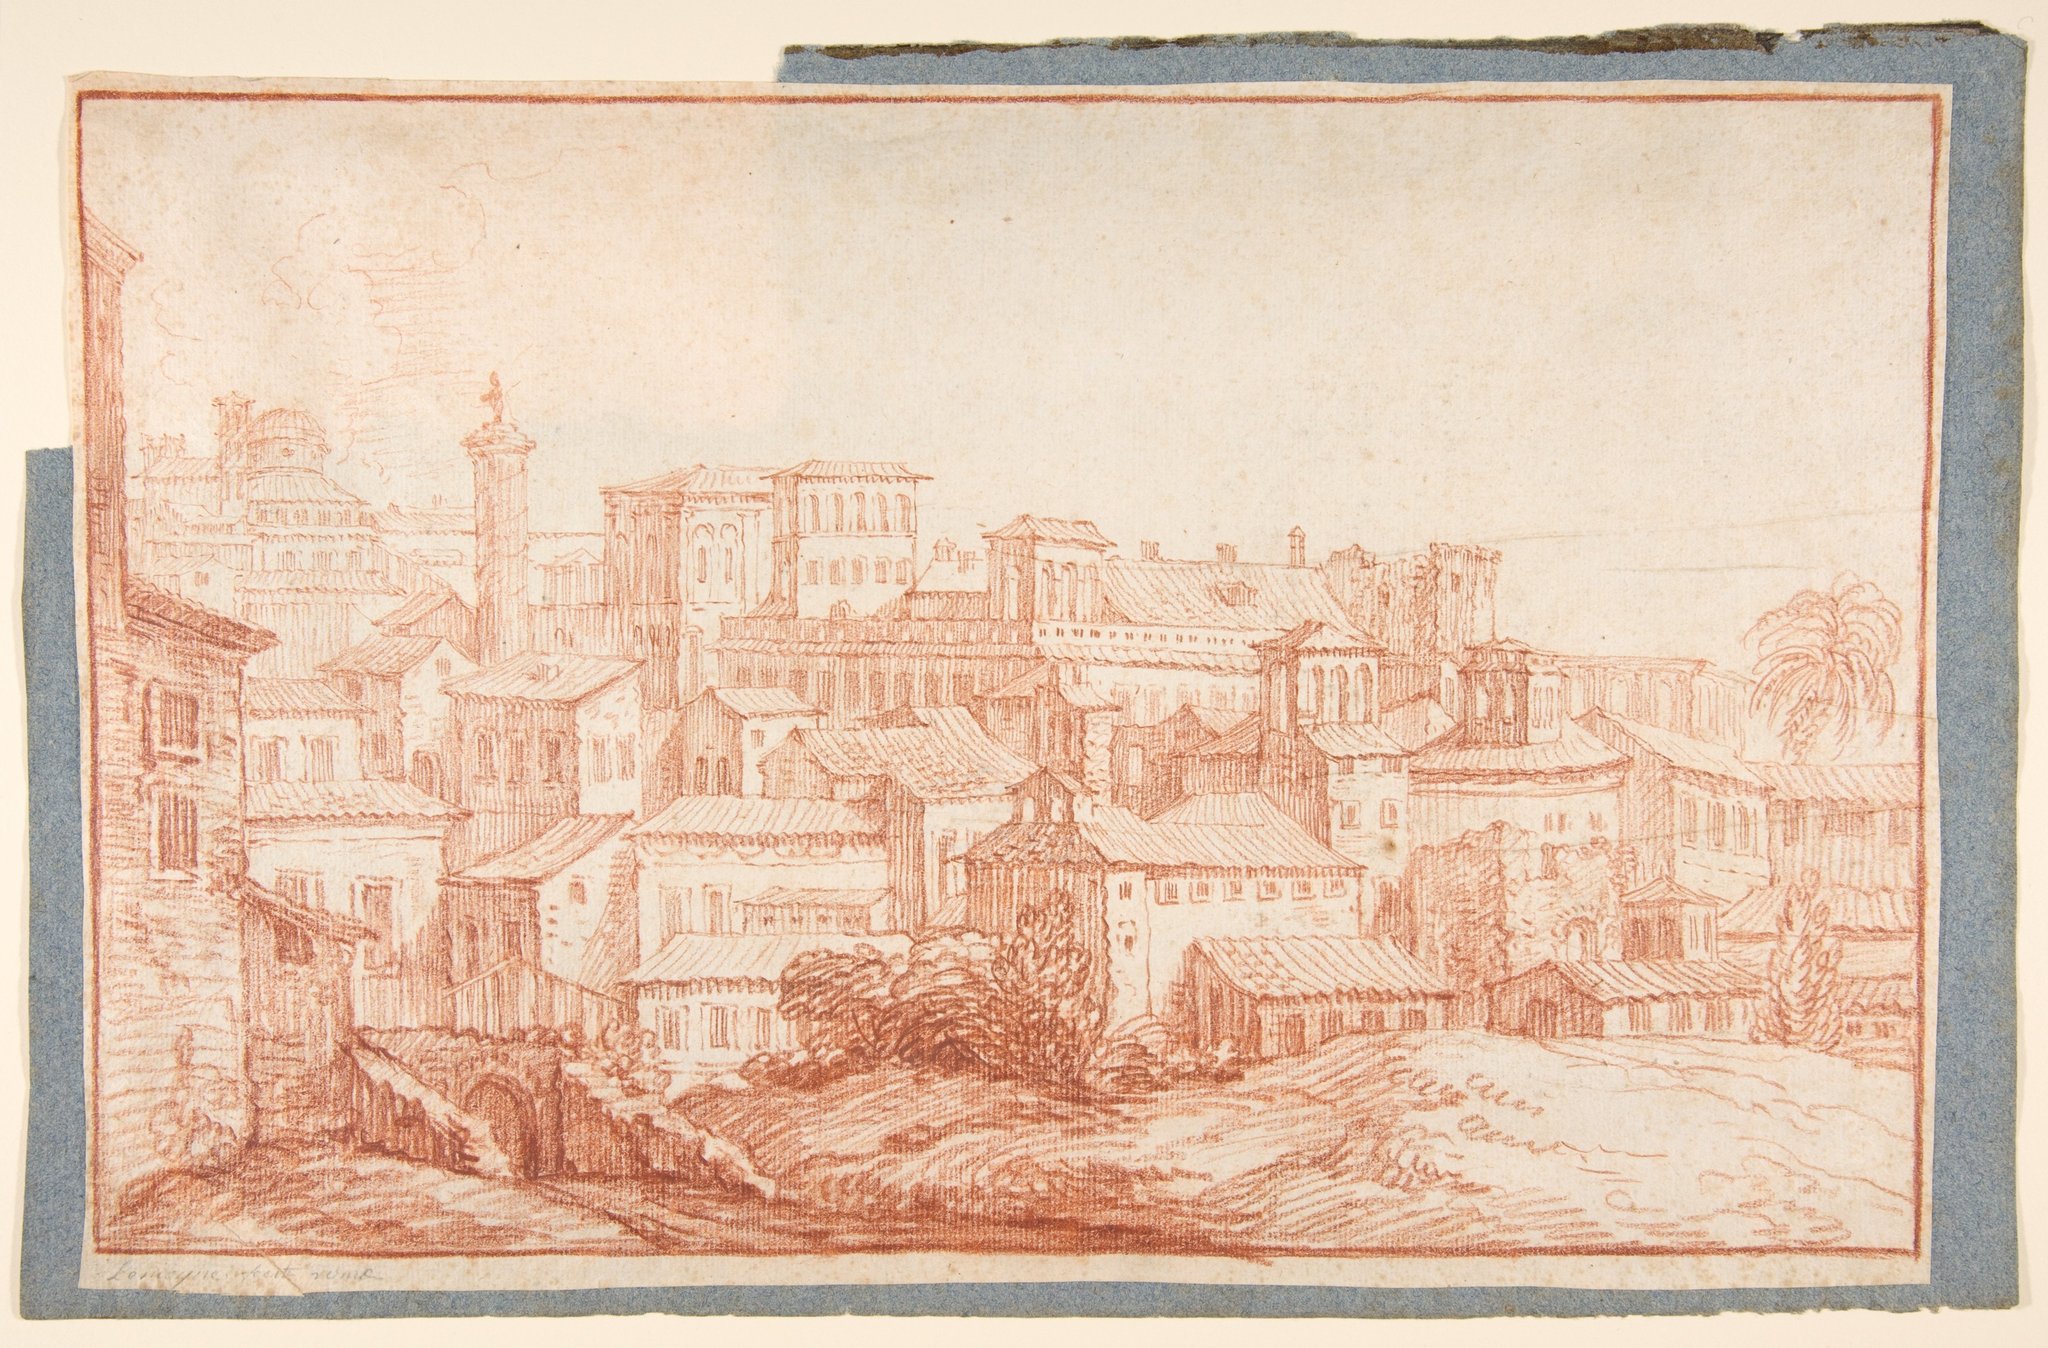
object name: drawing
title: View of Rome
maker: françois le moyne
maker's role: artist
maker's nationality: french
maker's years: 1688-1737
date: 1724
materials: chalk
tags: buildings,cities,rome